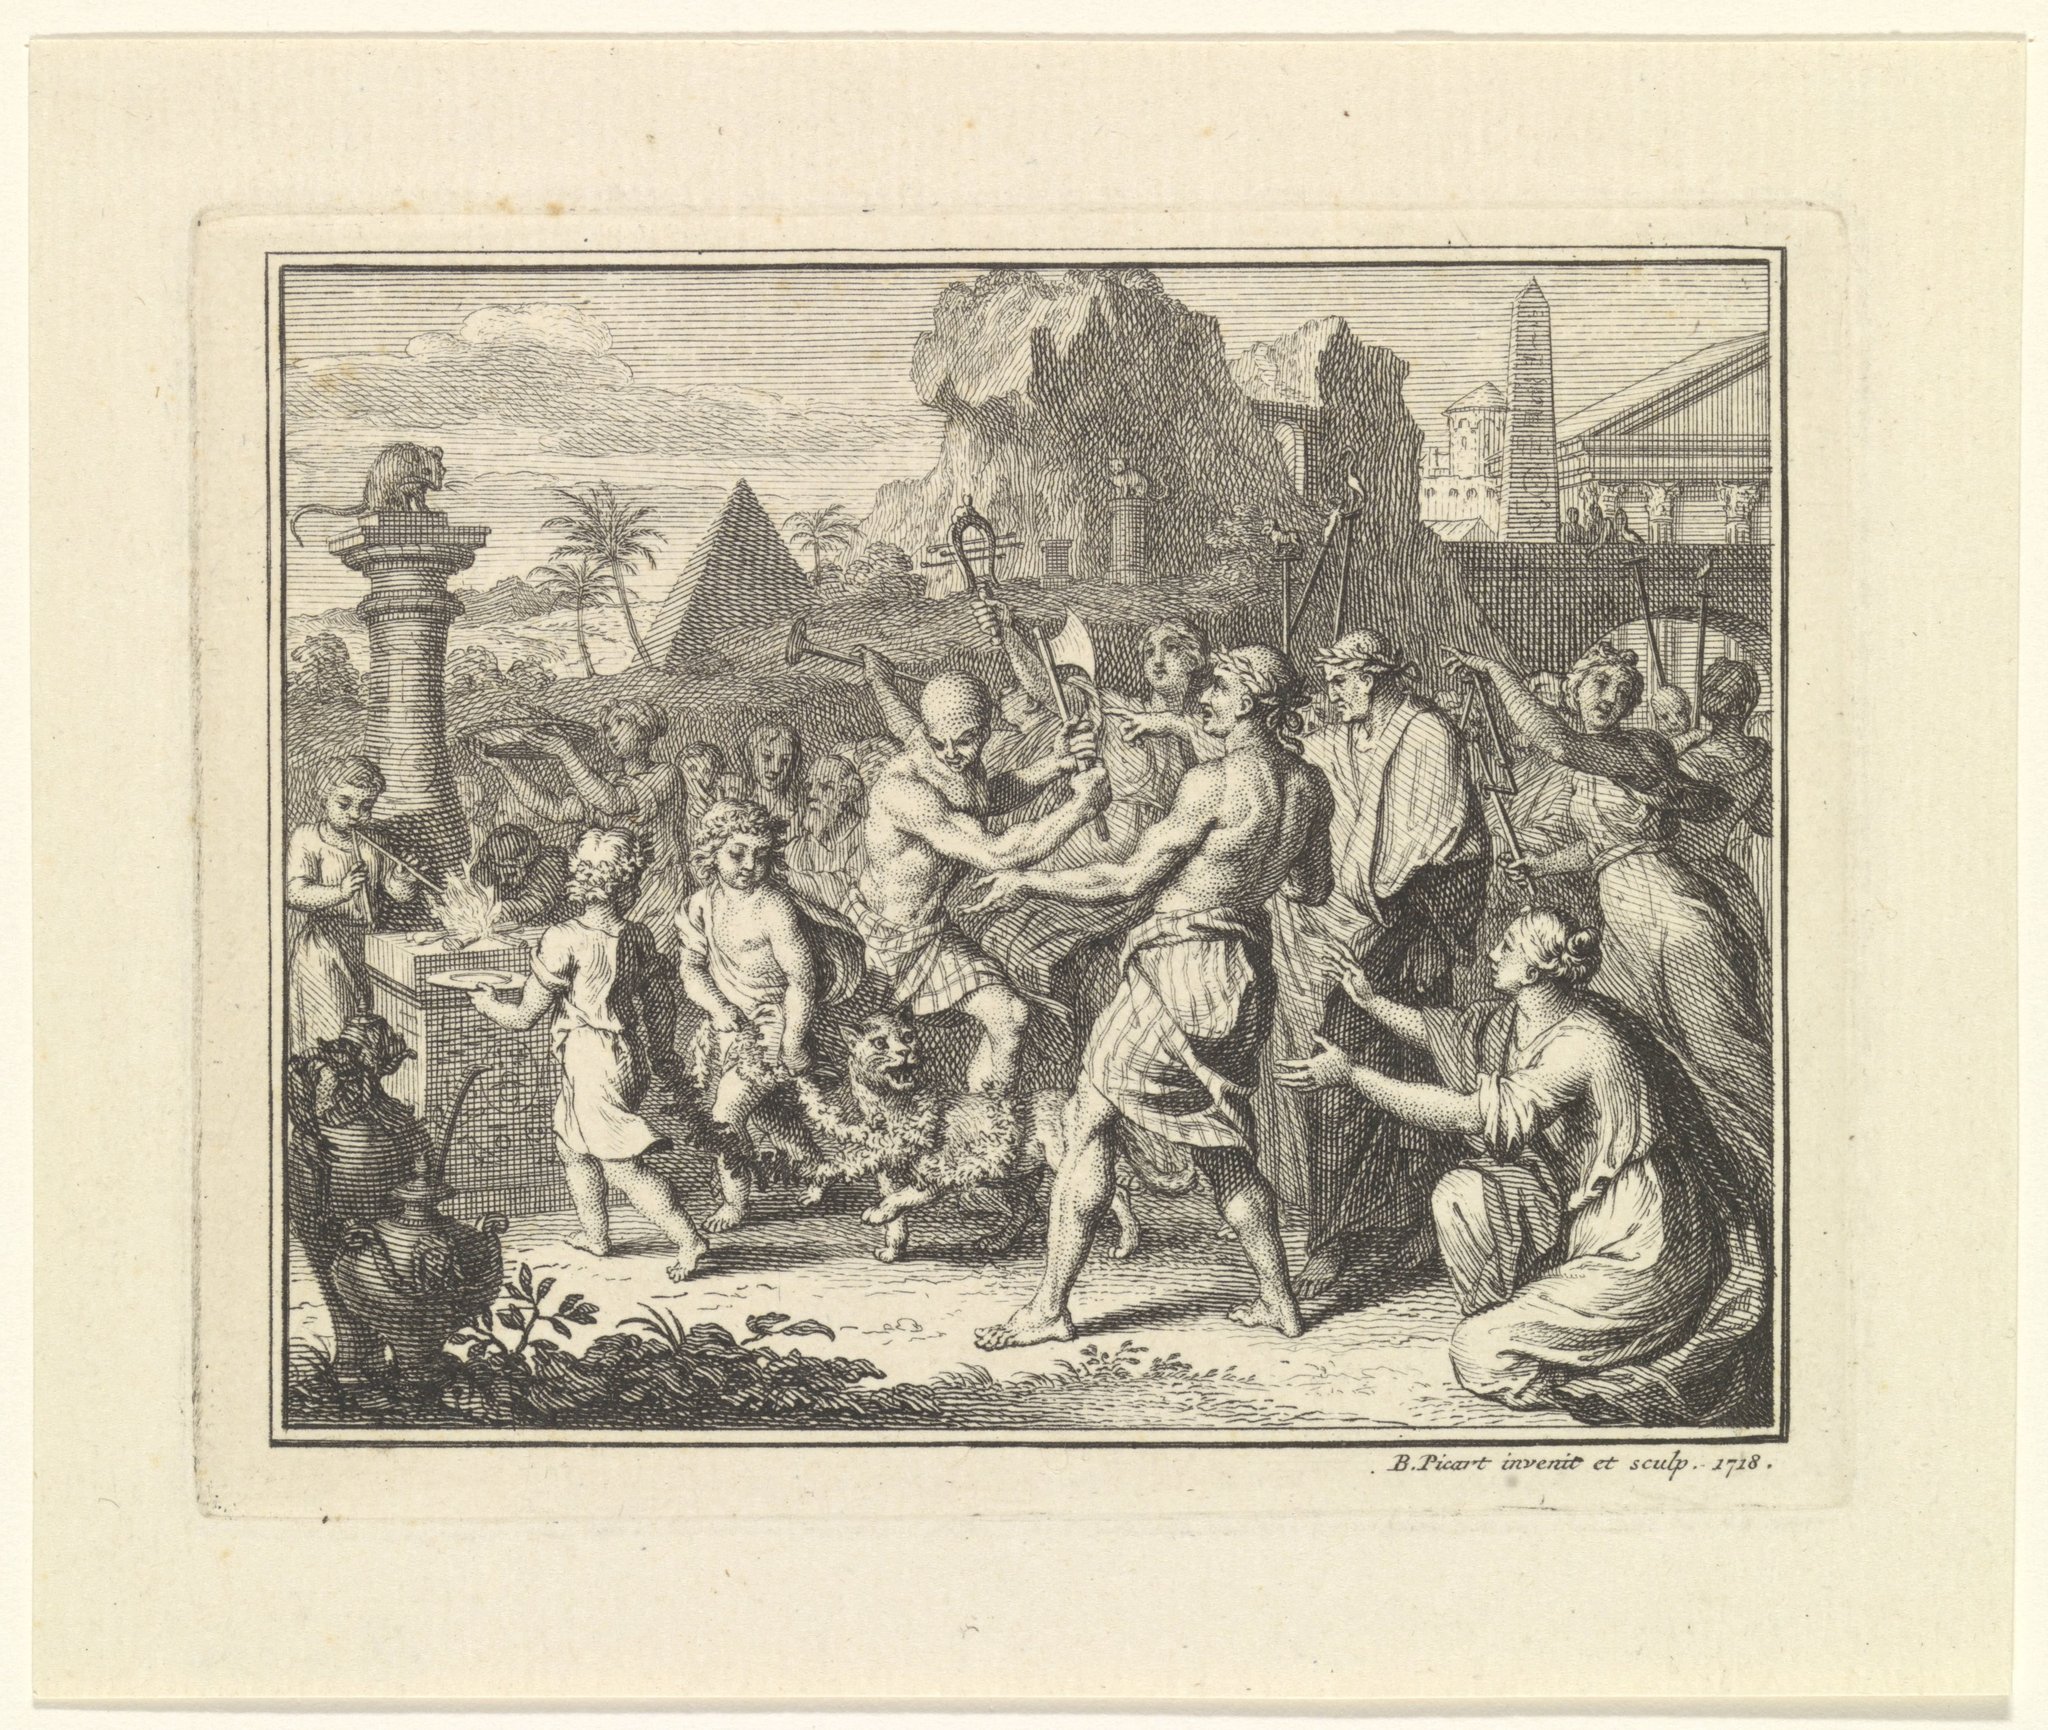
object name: print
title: Lynx(?) naar een offertafel geleid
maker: bernard picart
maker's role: draughtsman, print maker, publisher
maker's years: 1673-1733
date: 1718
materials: paper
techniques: engraving, etching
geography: amsterdam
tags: rodents: rat, beasts of prey, predatory animals: lynx, classical antiquity (historical epoch), sacrifice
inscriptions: collector's mark: Lugt 2228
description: Twee kinderen leiden een lynx(?) aan guirlandes naar het altaar. Omstanders kijken opgewonden toe. Een man staat met een bijl in zijn hand te wachten tot hij het dier kan offeren. Links brengt een vrouw een offer aan een rat op een zuil. Op de achtergrond antieke gebouwen.